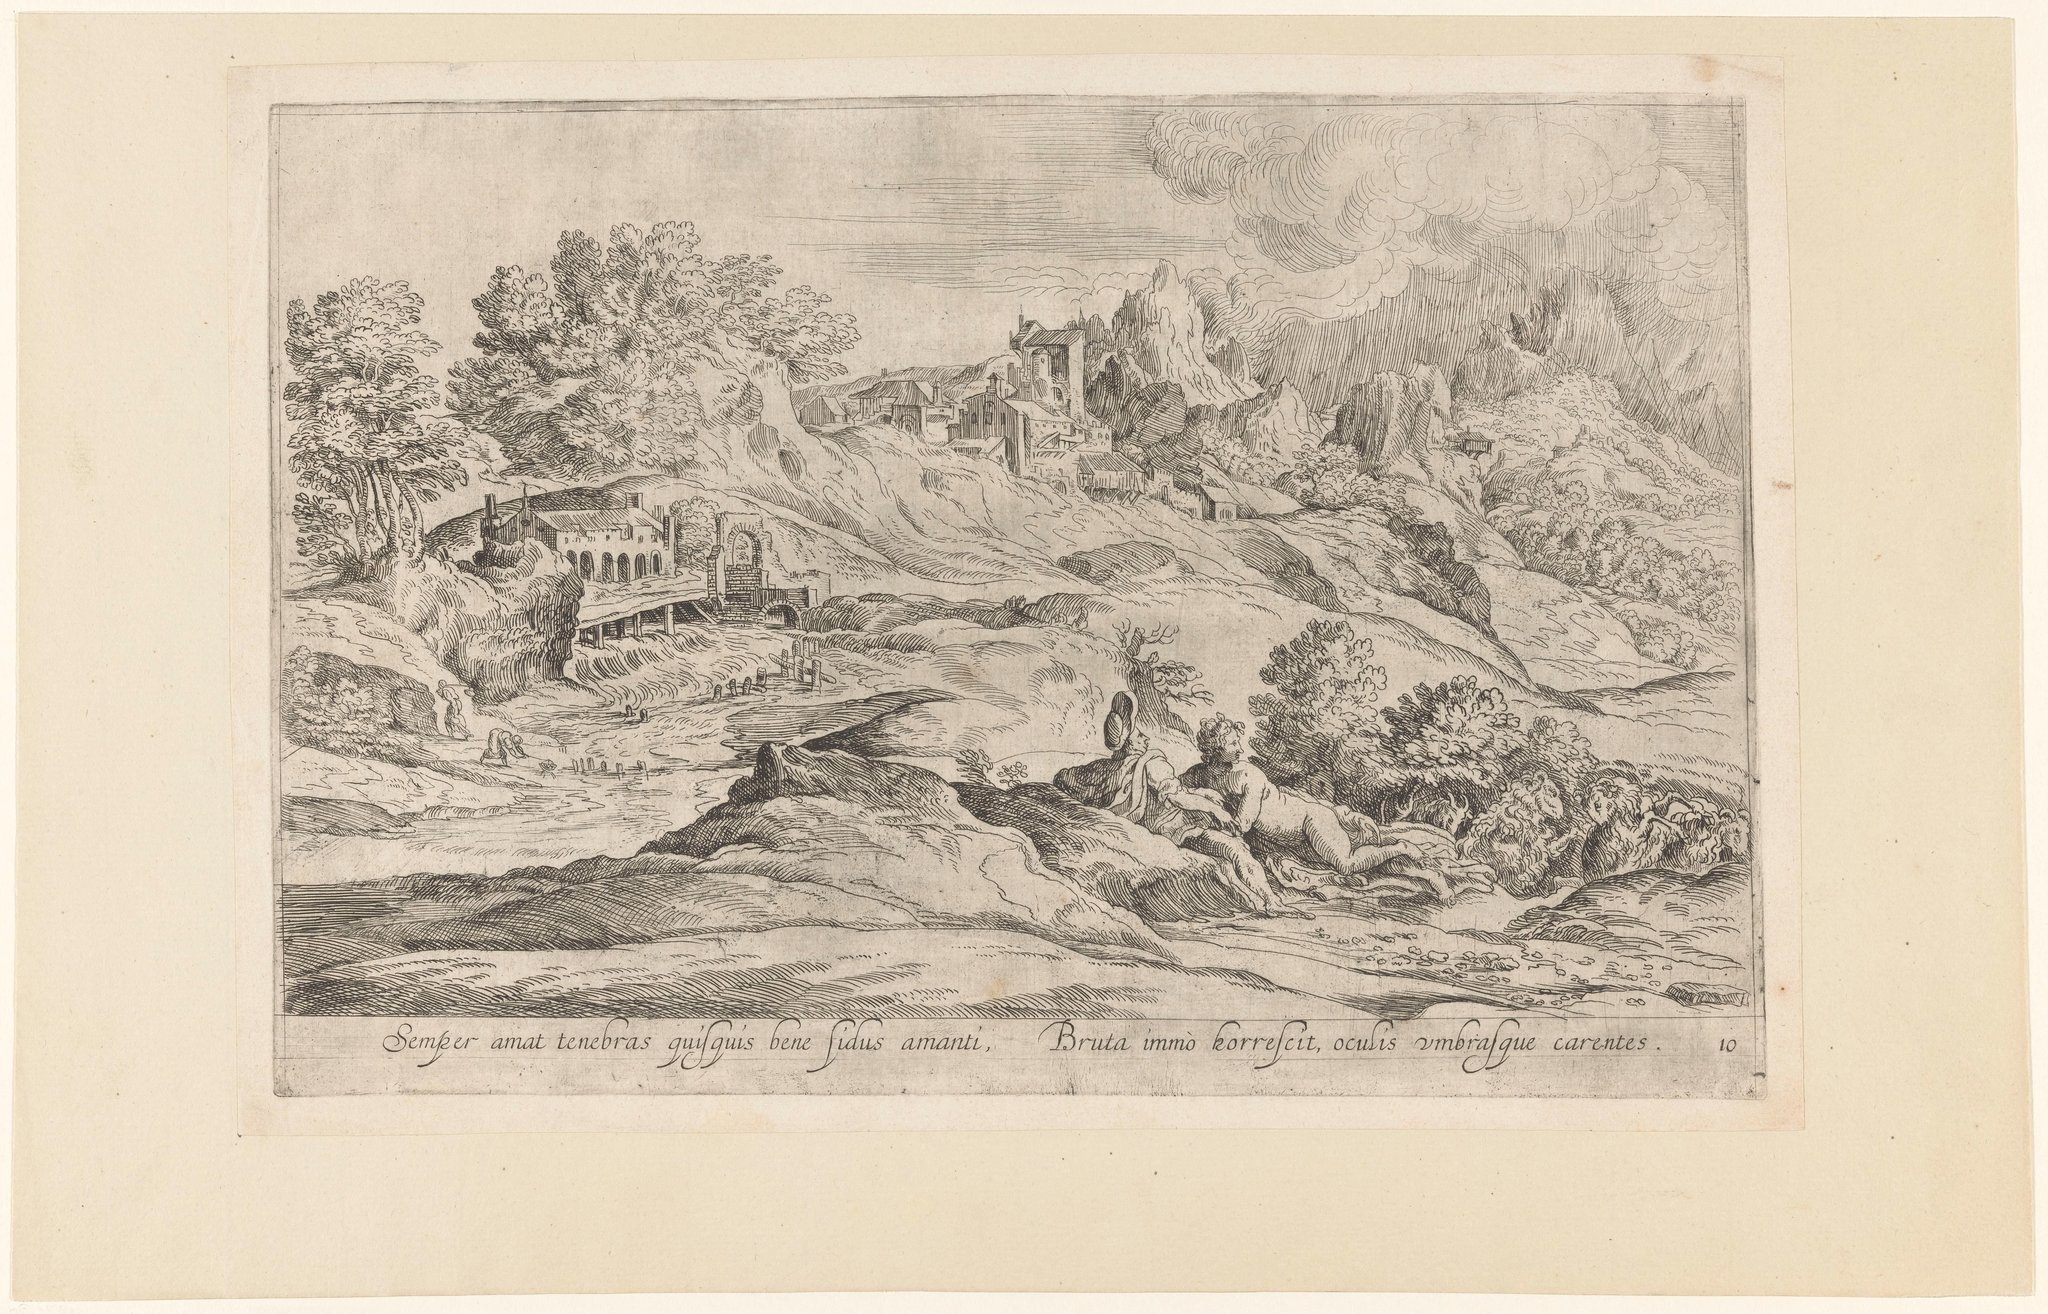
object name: print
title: Landschappen naar Domenico Campagnola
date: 1600-1699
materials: paper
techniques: etching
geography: italy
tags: landscapes, he-goat, billy-goat, couple of lovers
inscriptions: collector's mark: Lugt 2228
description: Heuvellandschap met bebouwing, een stroom en op de voorgrond een minnend paar bij een kudde bokken. Titel in het Latijn in ondermarge. Genummerd rechtsonder: 10.